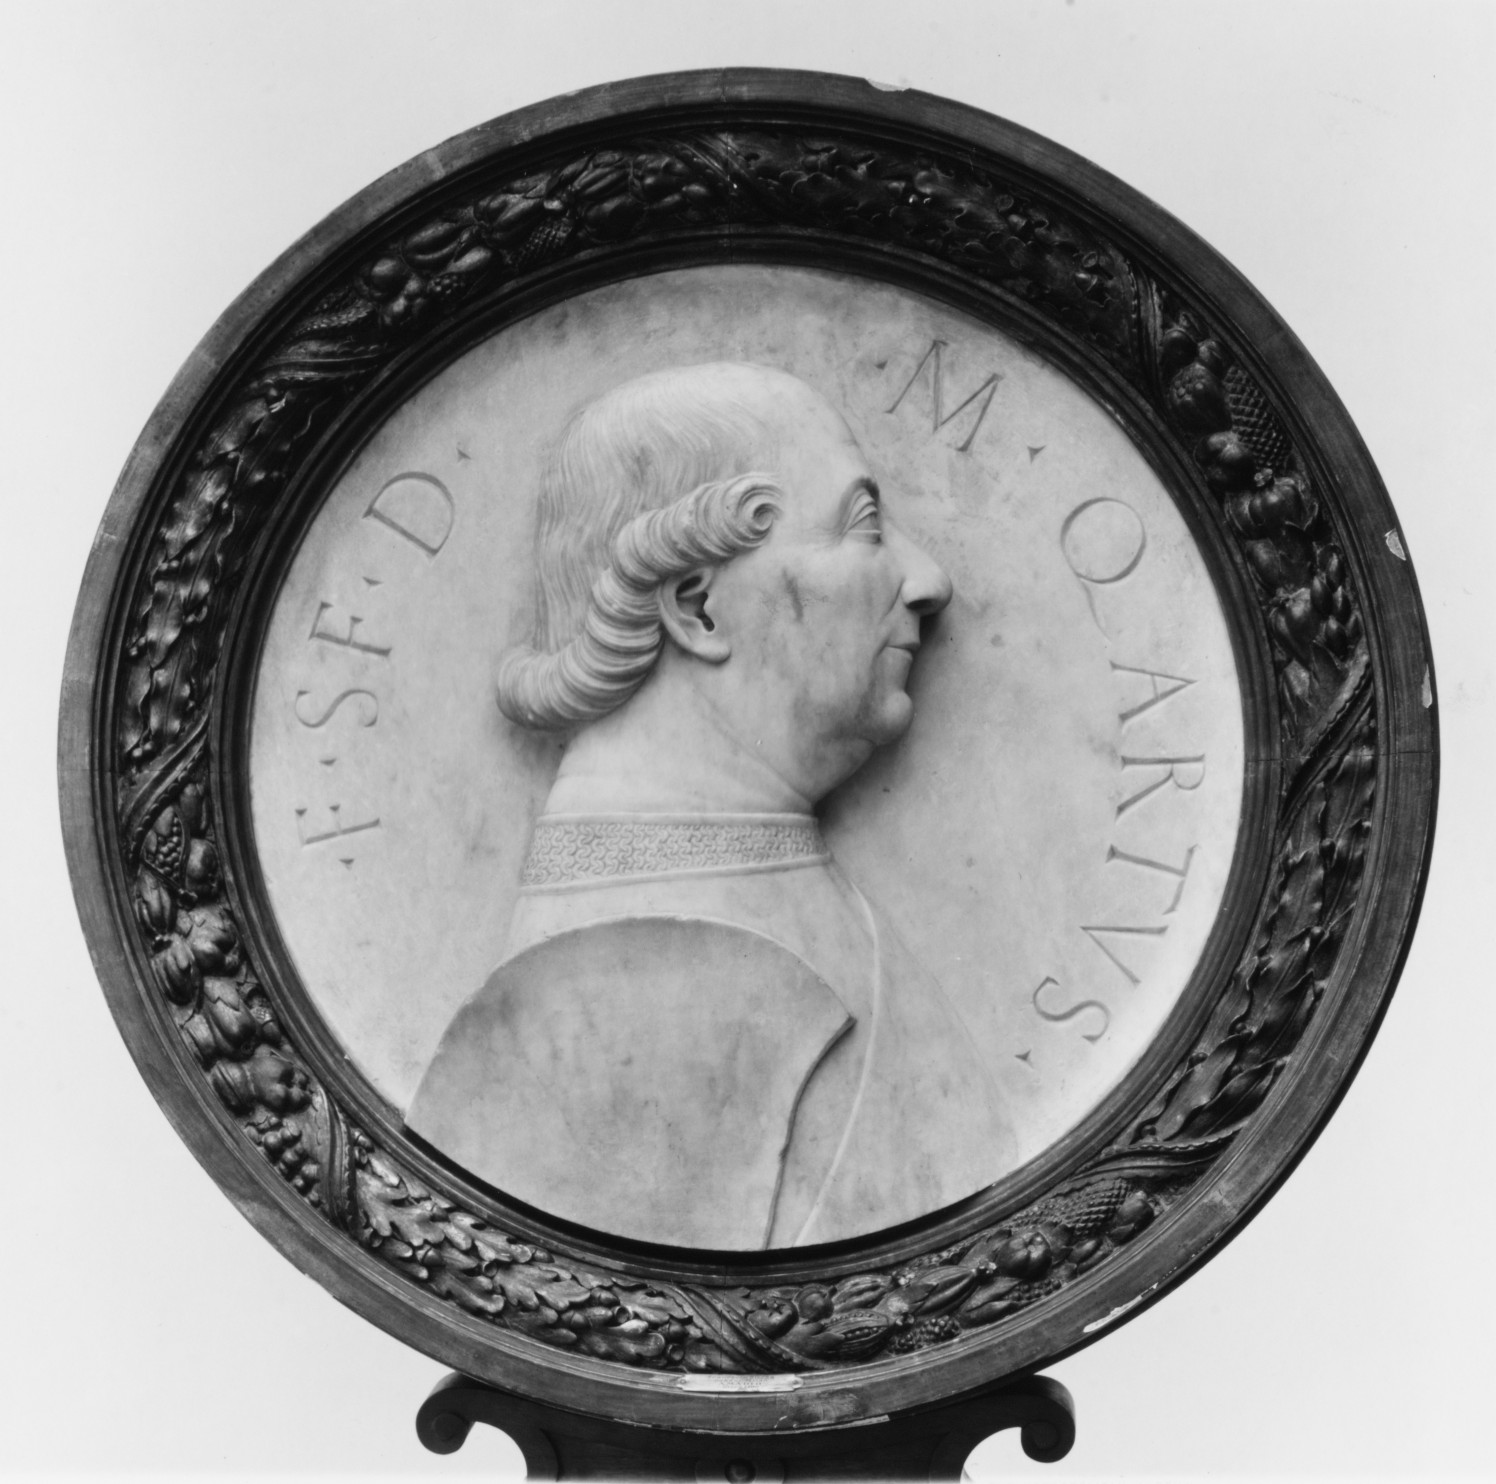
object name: relief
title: Francesco Sforza (1401–1466), Fourth Duke of Milan (r. 1450–66)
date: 1467-1500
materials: marble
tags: men,profiles